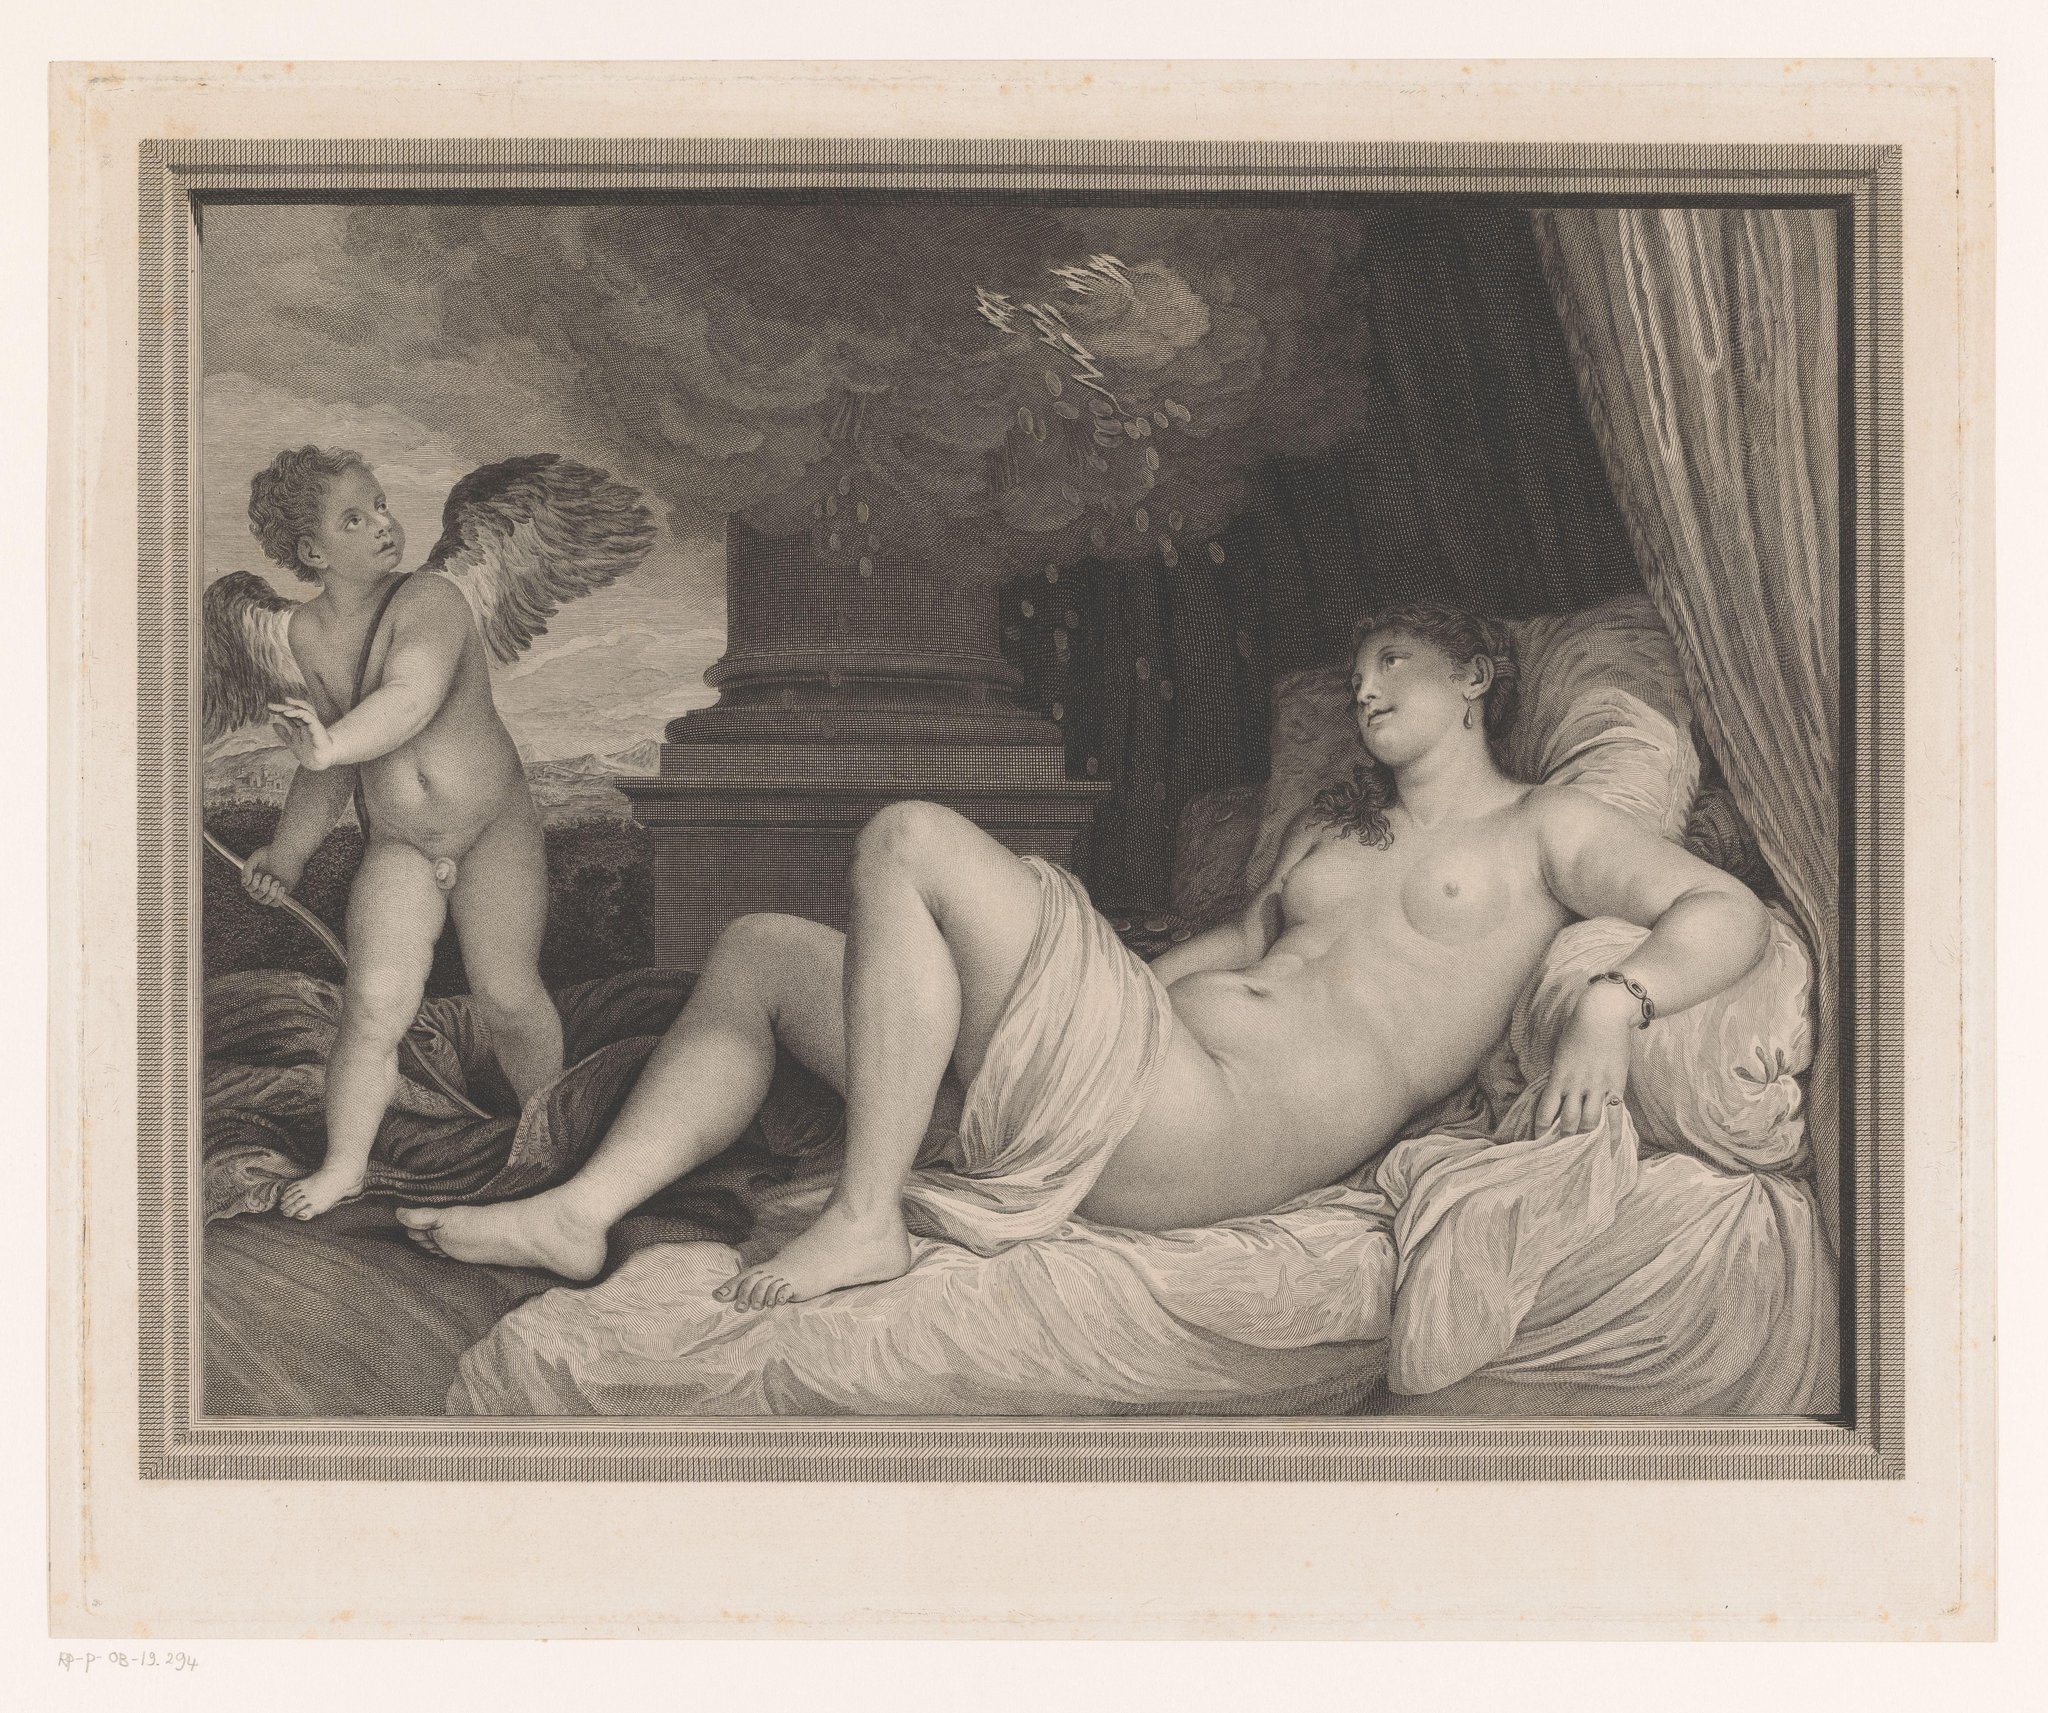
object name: print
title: Jupiter verschijnt als gouden regen aan Danaë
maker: robert strange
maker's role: print maker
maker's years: 1721-1792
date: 1768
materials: paper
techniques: etching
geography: naples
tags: jupiter wooing danae; she is usually lying in bed receiving a shower of gold, (story of) danae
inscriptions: collector's mark: Lugt 2228